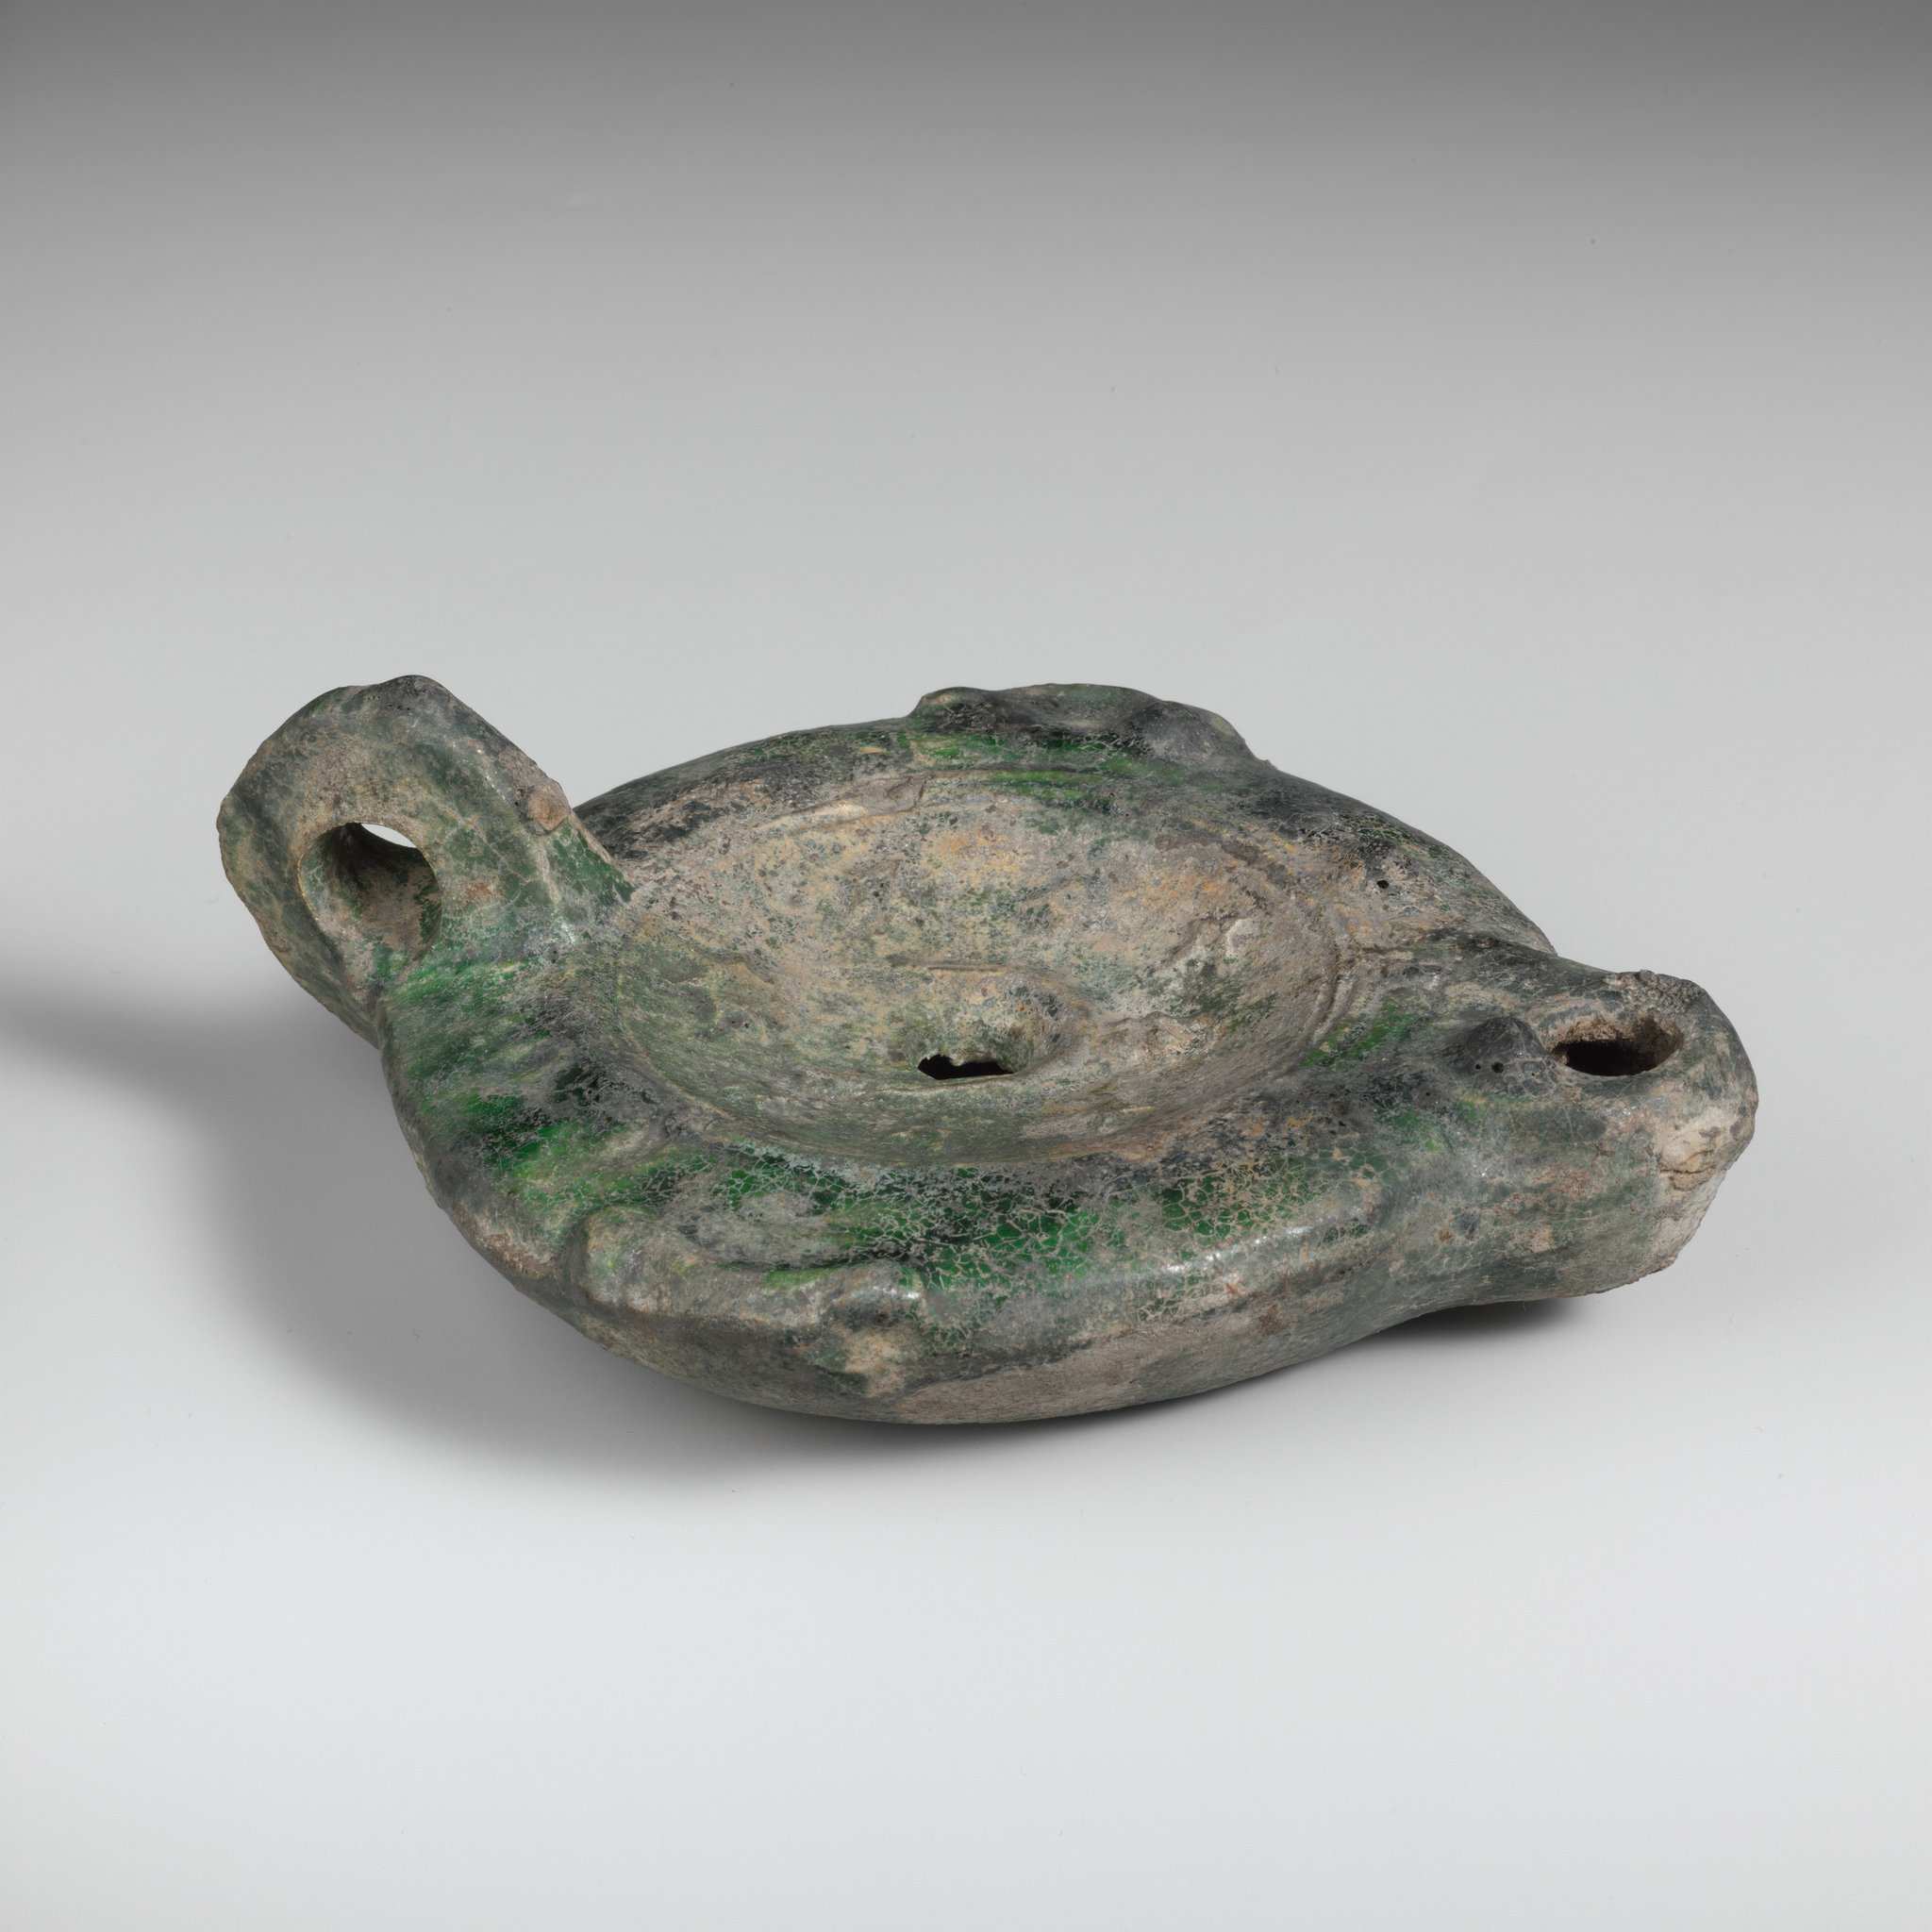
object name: lamp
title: Terracotta lead-glazed lamp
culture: roman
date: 101-150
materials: terracotta